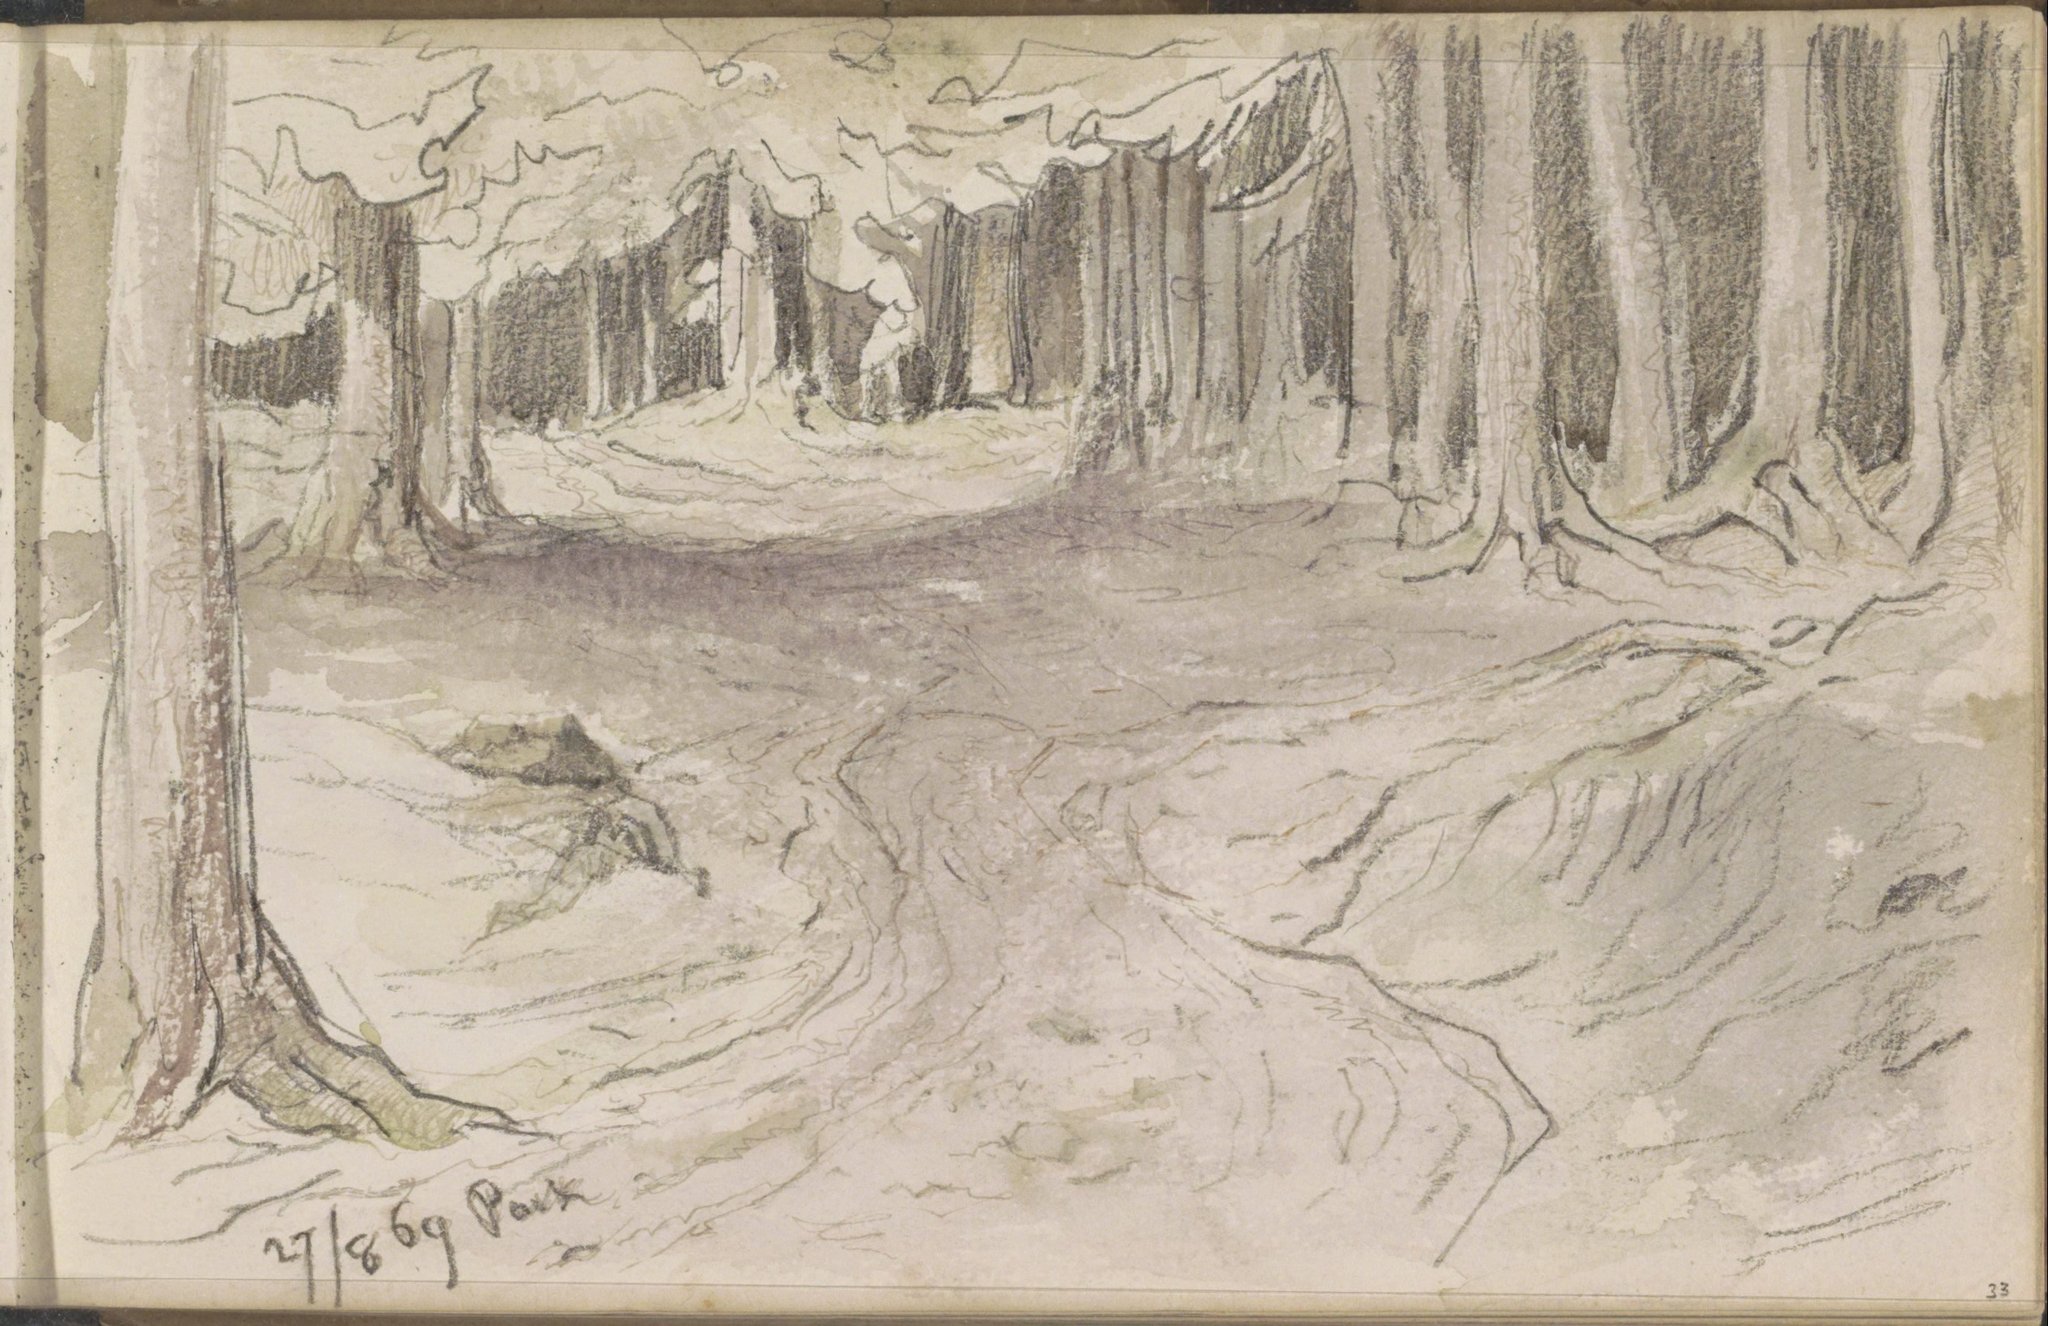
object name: sketchbook leaf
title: Bospad in het park van Metternich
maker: johannes tavenraat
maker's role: draughtsman, painter, print maker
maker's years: 1809-1881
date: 1808-1869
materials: paper, pencil, watercolor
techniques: brush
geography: marienbad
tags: forest path or lane, marienbad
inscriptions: date and inscription: ‘27/8 69 Park’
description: Blad 33 recto uit een schetsboek met 48 bladen.